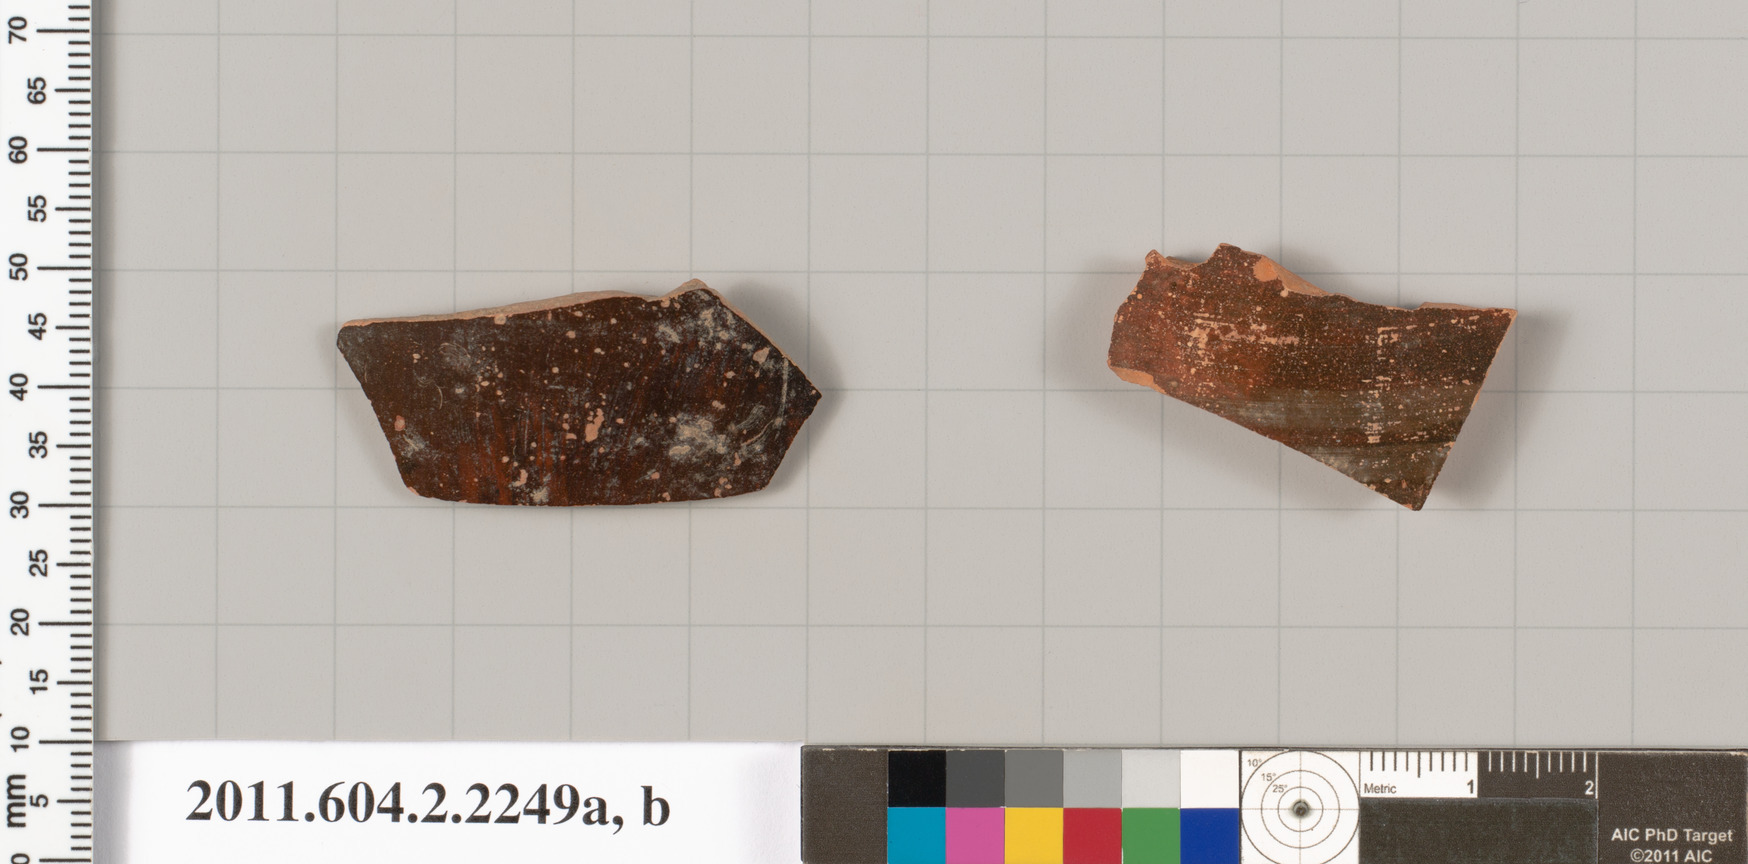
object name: pot fragment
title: Terracotta fragments of pots; unglazed on the inside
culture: greek, attic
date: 600-401 BCE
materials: terracotta